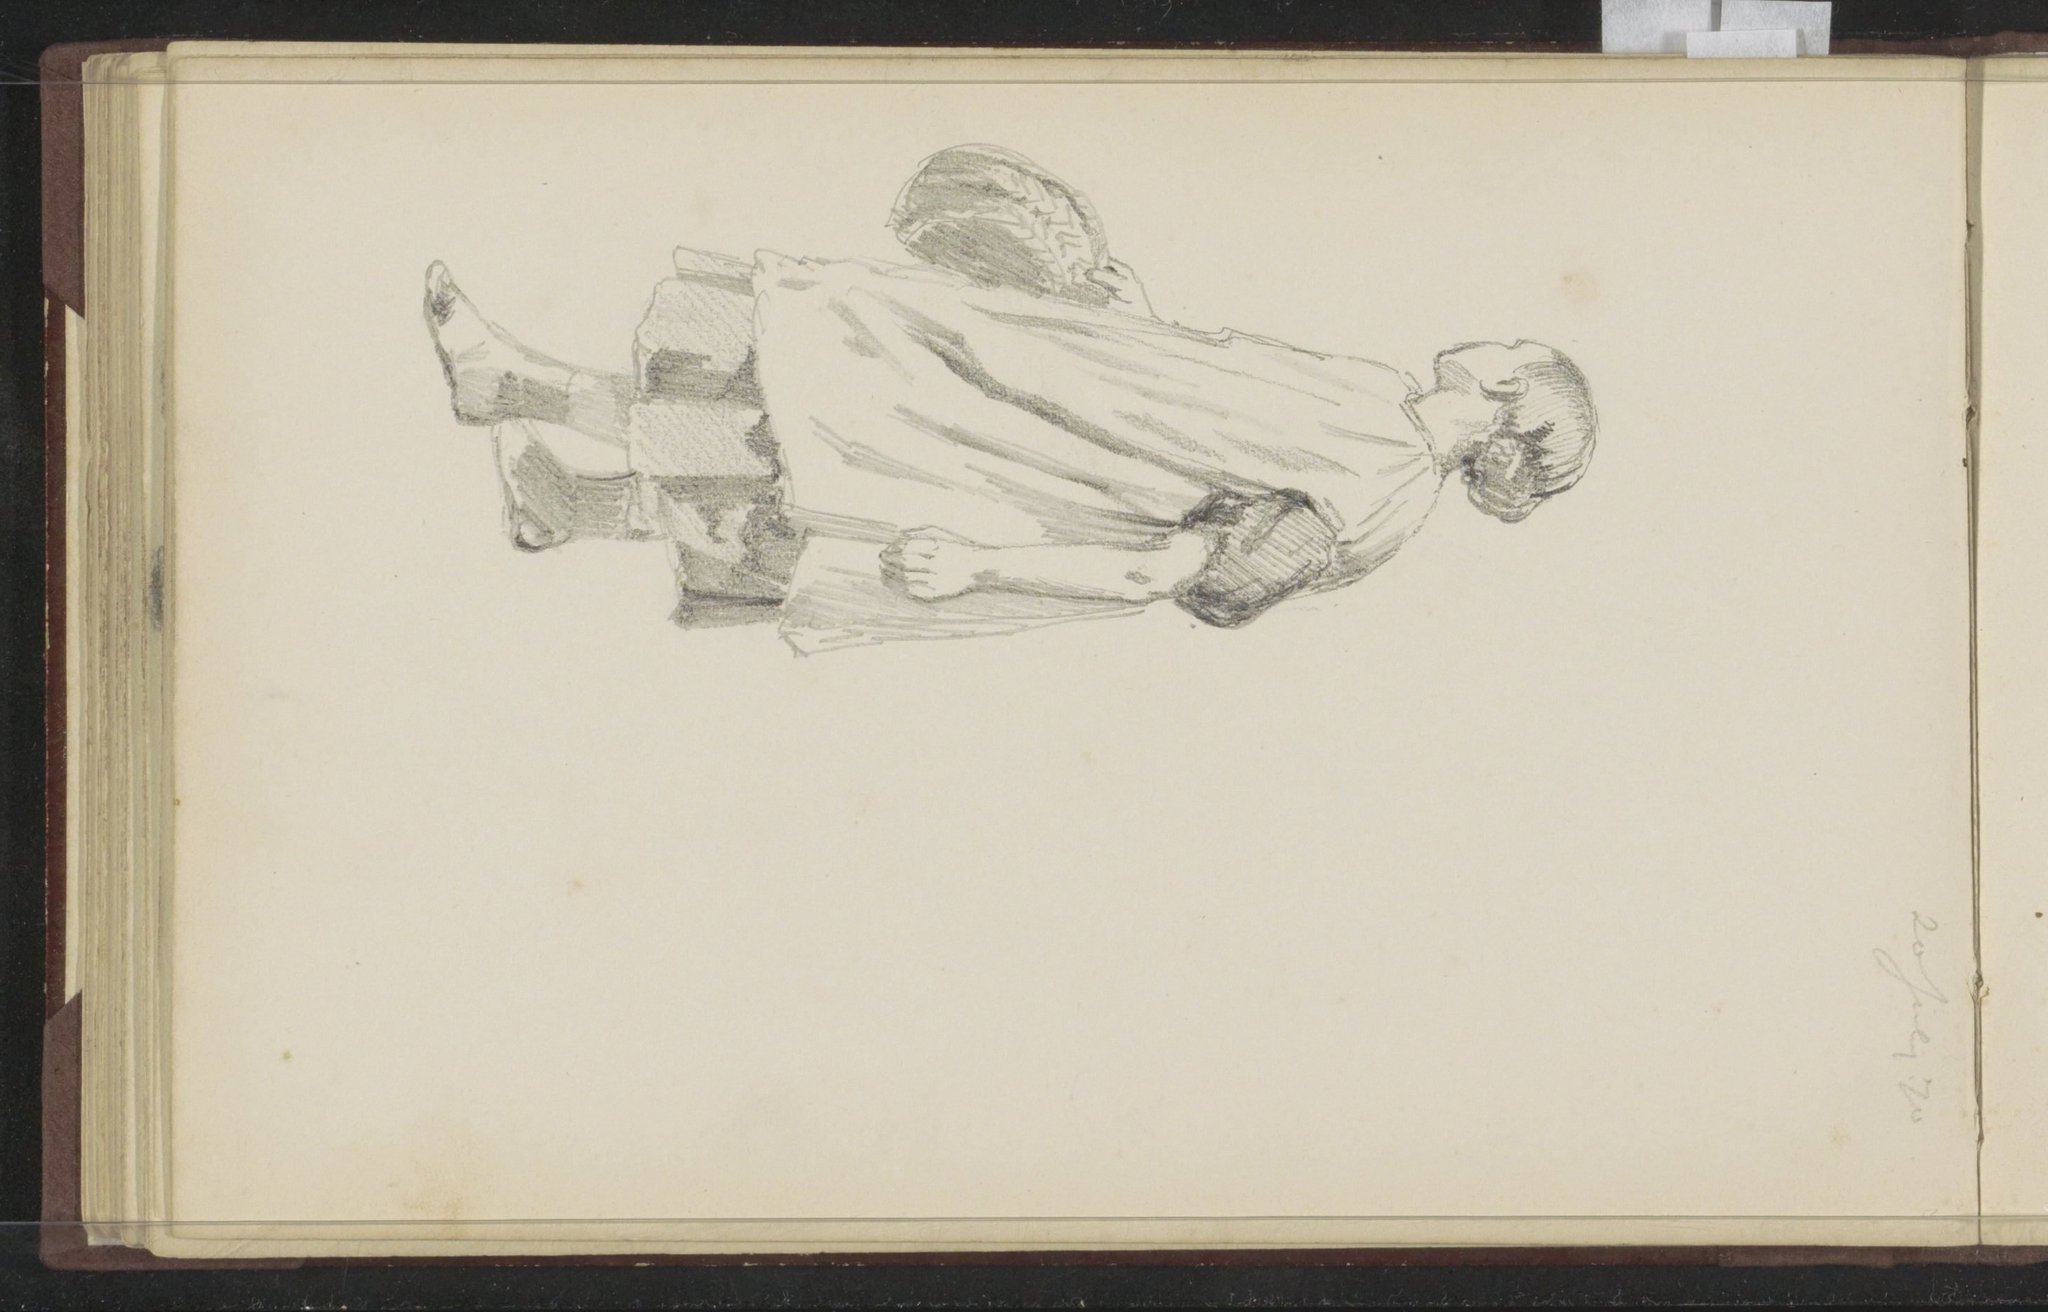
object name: sketchbook leaf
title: Jonge vrouw met een mand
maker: cornelis springer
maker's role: draughtsman, painter, print maker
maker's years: 1817-1891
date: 1870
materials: paper, pencil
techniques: stumping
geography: netherlands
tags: adolescent, young woman, maiden, container made of plant material other than wood: basket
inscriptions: date: ‘20 July 70’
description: Jonge vrouw met een mand. Blad 25 verso uit een schetsboek met 39 bladen, deels vervaardigd te Ulm en Leiden.